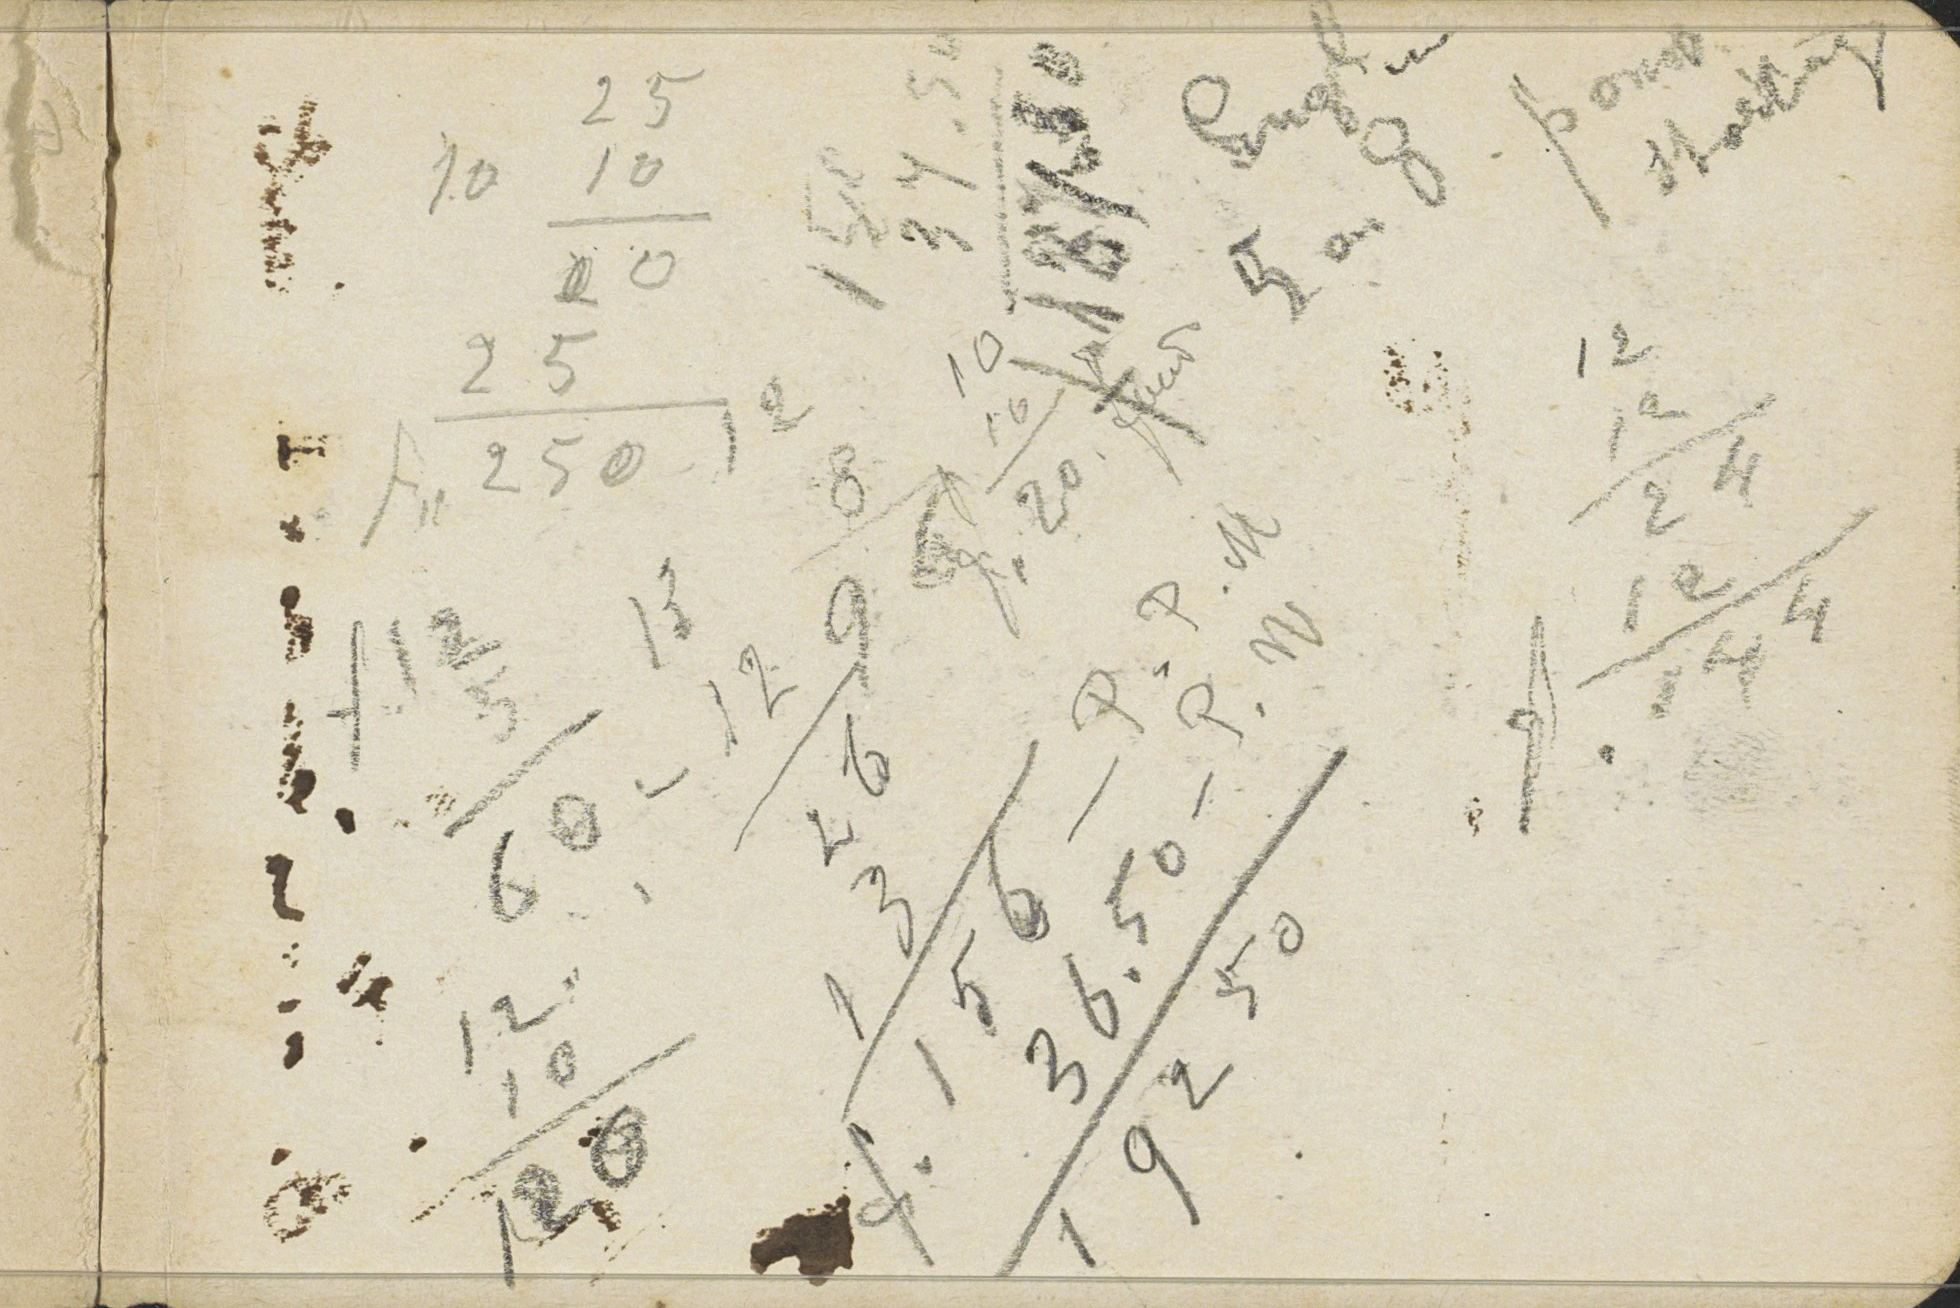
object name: sketchbook leaf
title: Notities en berekeningen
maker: willem cornelis rip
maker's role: draughtsman, painter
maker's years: 1856-1922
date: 1919-1921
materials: chalk, paper, pencil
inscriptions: annotation: ‘[...]’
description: Achterste schutblad uit een schetsboek met 42 bladen.